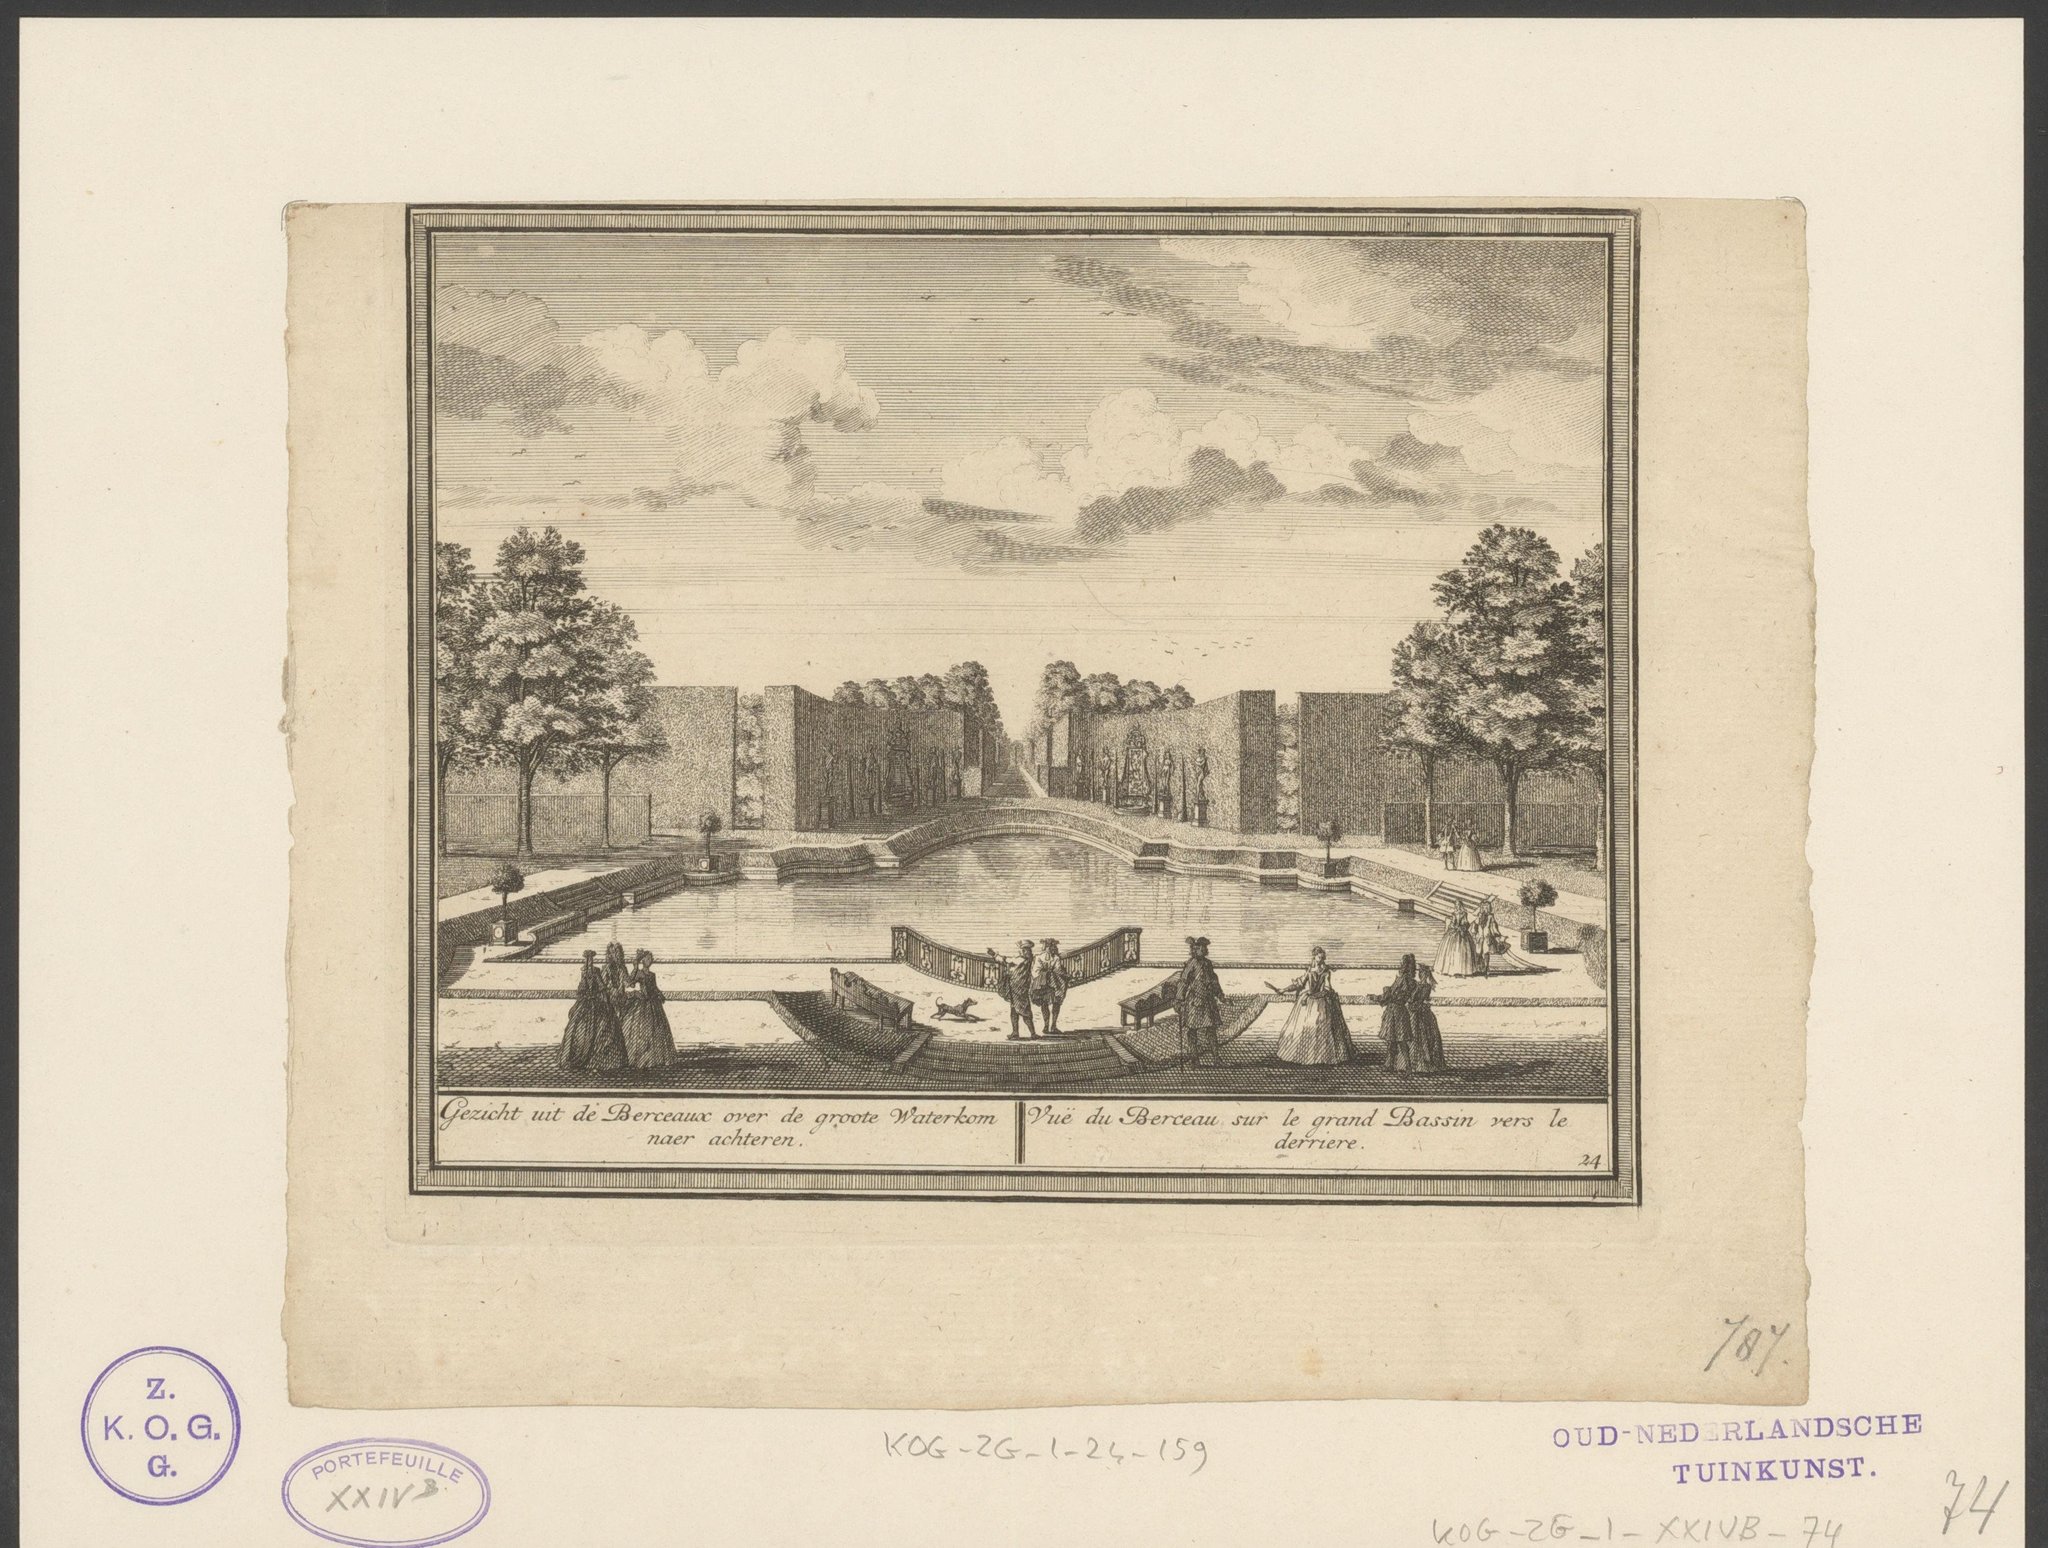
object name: print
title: Gezicht uit de Berceaux over de groote Waterkom naer achteren / Vuë du Berceau sur le grand Bassin vers le derriere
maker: hendrik de leth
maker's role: draughtsman, print maker, publisher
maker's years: 1703-1766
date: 1729-1732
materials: paper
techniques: engraving, etching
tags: french or architectonic garden; formal garden, garden pond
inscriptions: stamp, stamp, collector's mark: Lugt 1641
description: Prent mogelijk uit: Brouërius van Nidek, Matthaeus. Het zegepralend Kennemerland, vertoond in 100 heerlyke gezichten. Amsterdam: Jan Roman, s.a. Of uit: Brouërius van Nidek, Matthaeus. Het zegepralend Kennemerland, vertoond in veele heerlyke gezichten. Amsterdam: Andries en Hendrik de Leth, s.a [1729-1732].